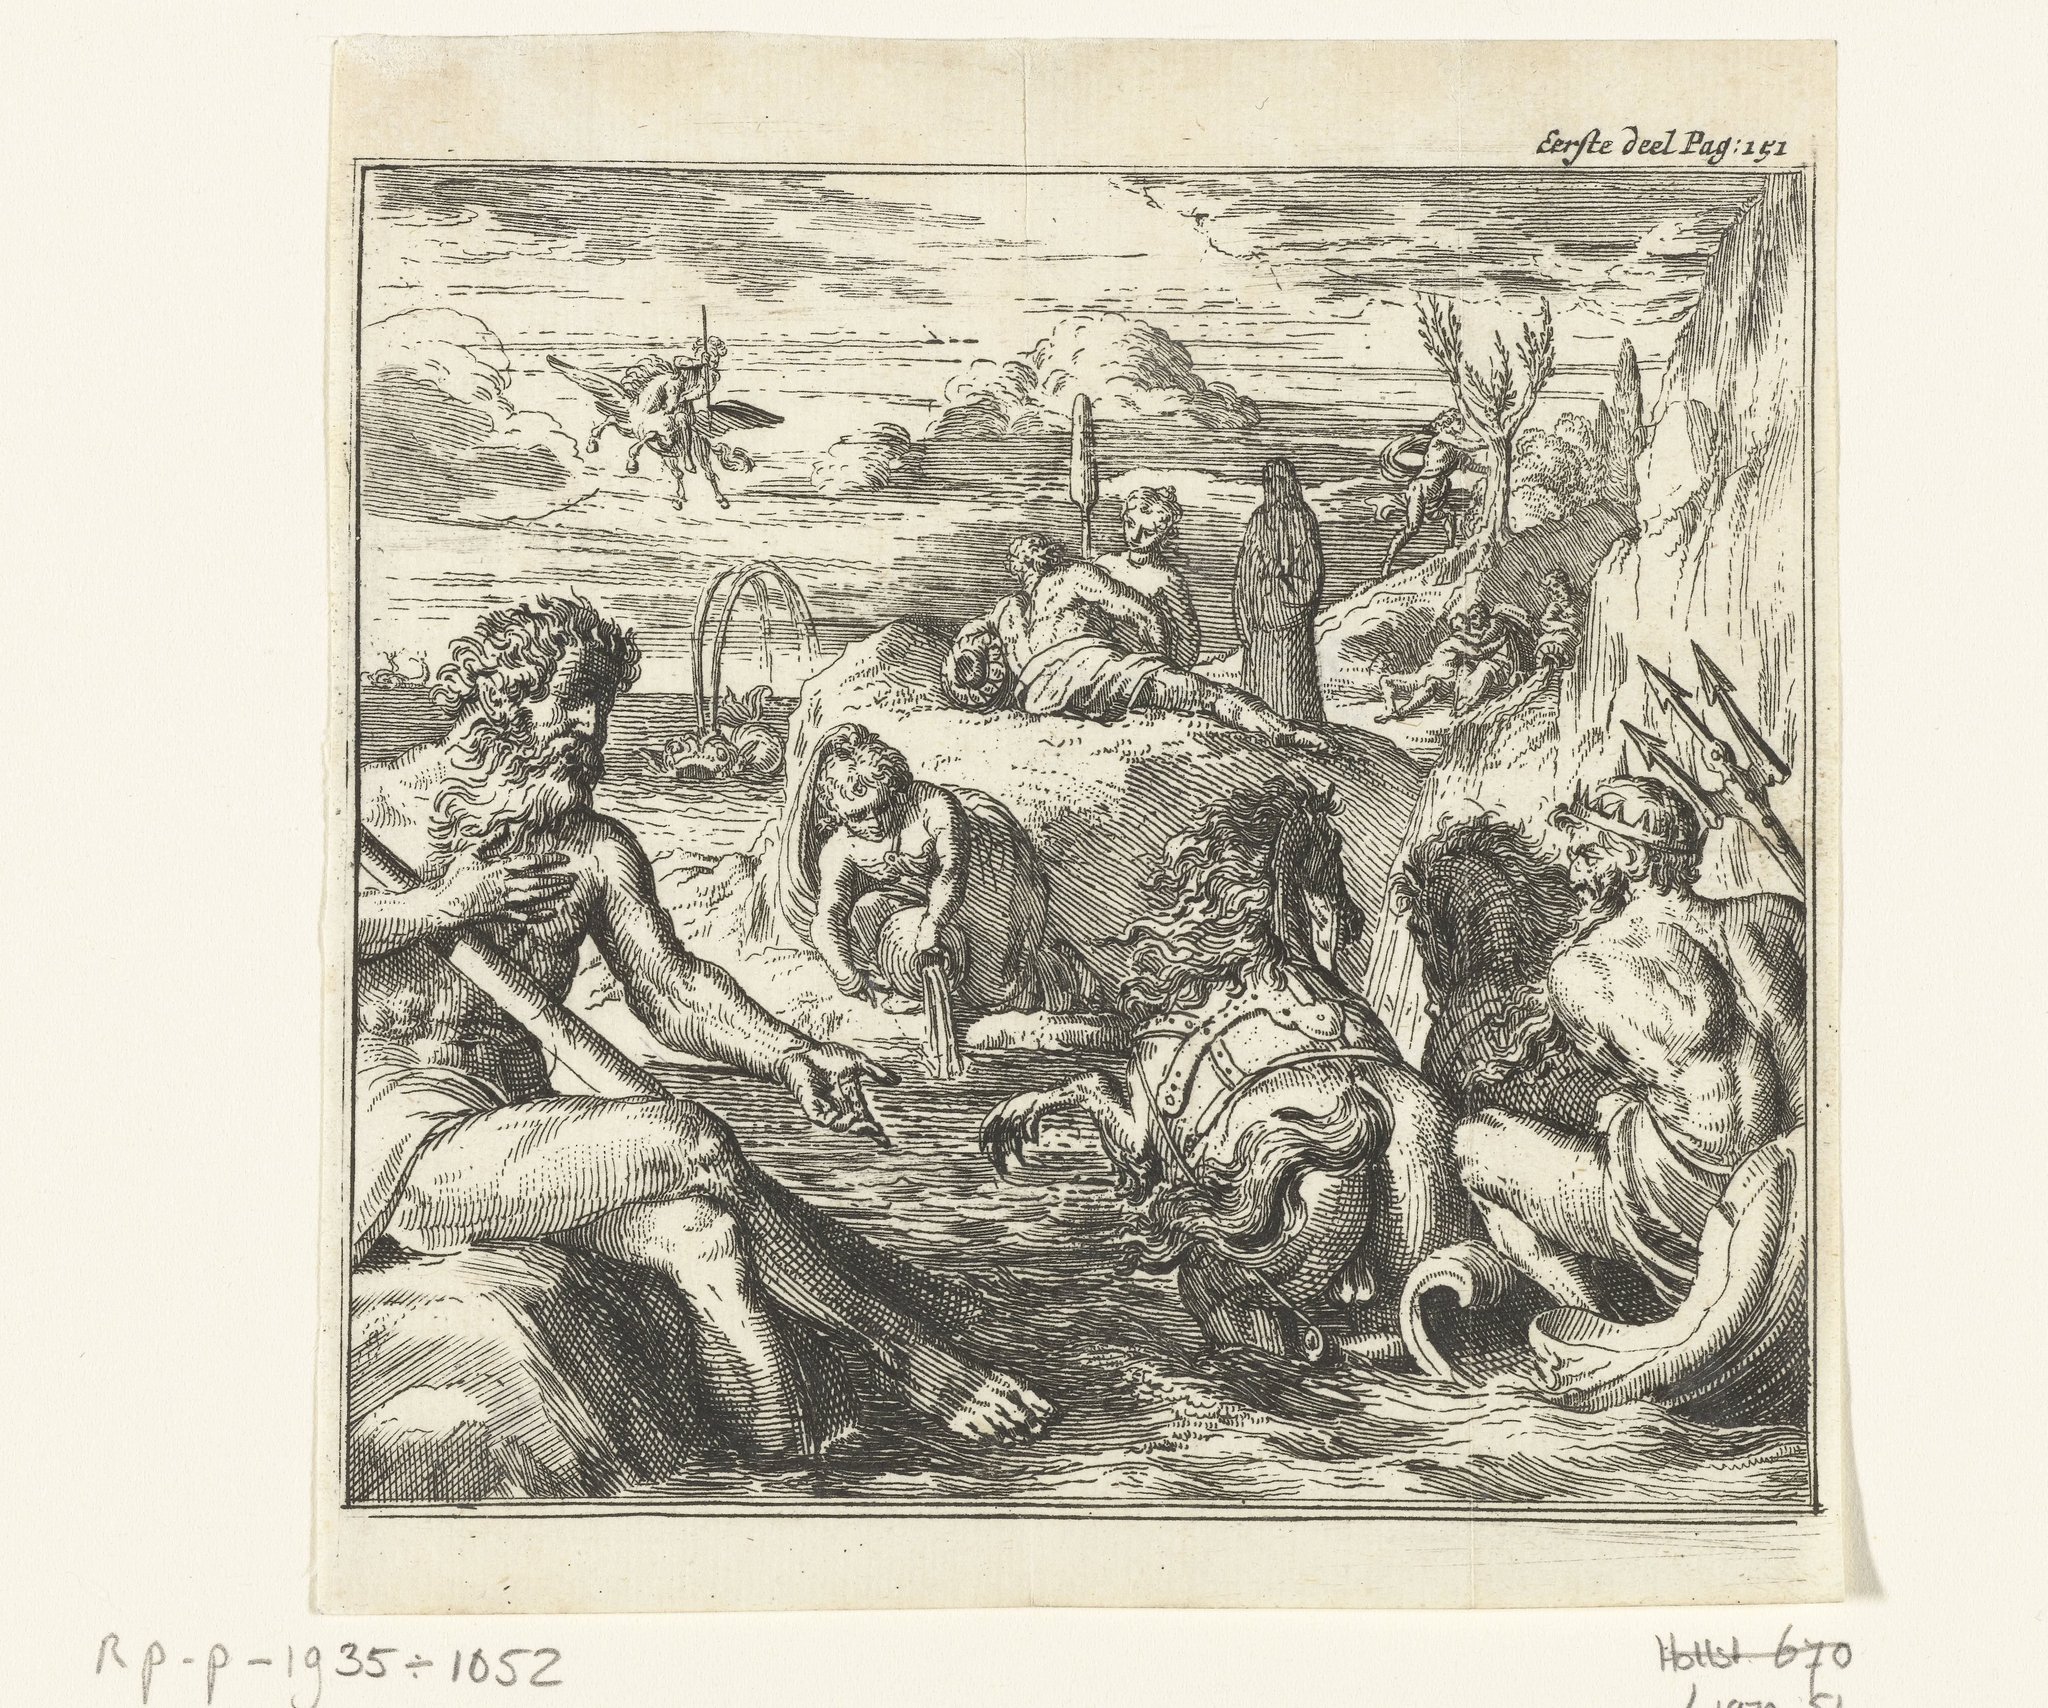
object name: print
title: Illustratie voor 'Alle de werken' van Lucianus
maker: romeyn de hooghe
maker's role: draughtsman, goldsmith, painter, print maker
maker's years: 1645-1708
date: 1679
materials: paper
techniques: etching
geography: amsterdam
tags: (story of) neptune (poseidon), perseus, riding on pegasus, kills the sea monster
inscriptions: collector's mark: Lugt 2760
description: Op de voorgrond Neptunus met zijn drietand. Links op de achtergrond Perseus op het gevleugelde paard Pegasus, op het punt een zeemonster aan te vallen.